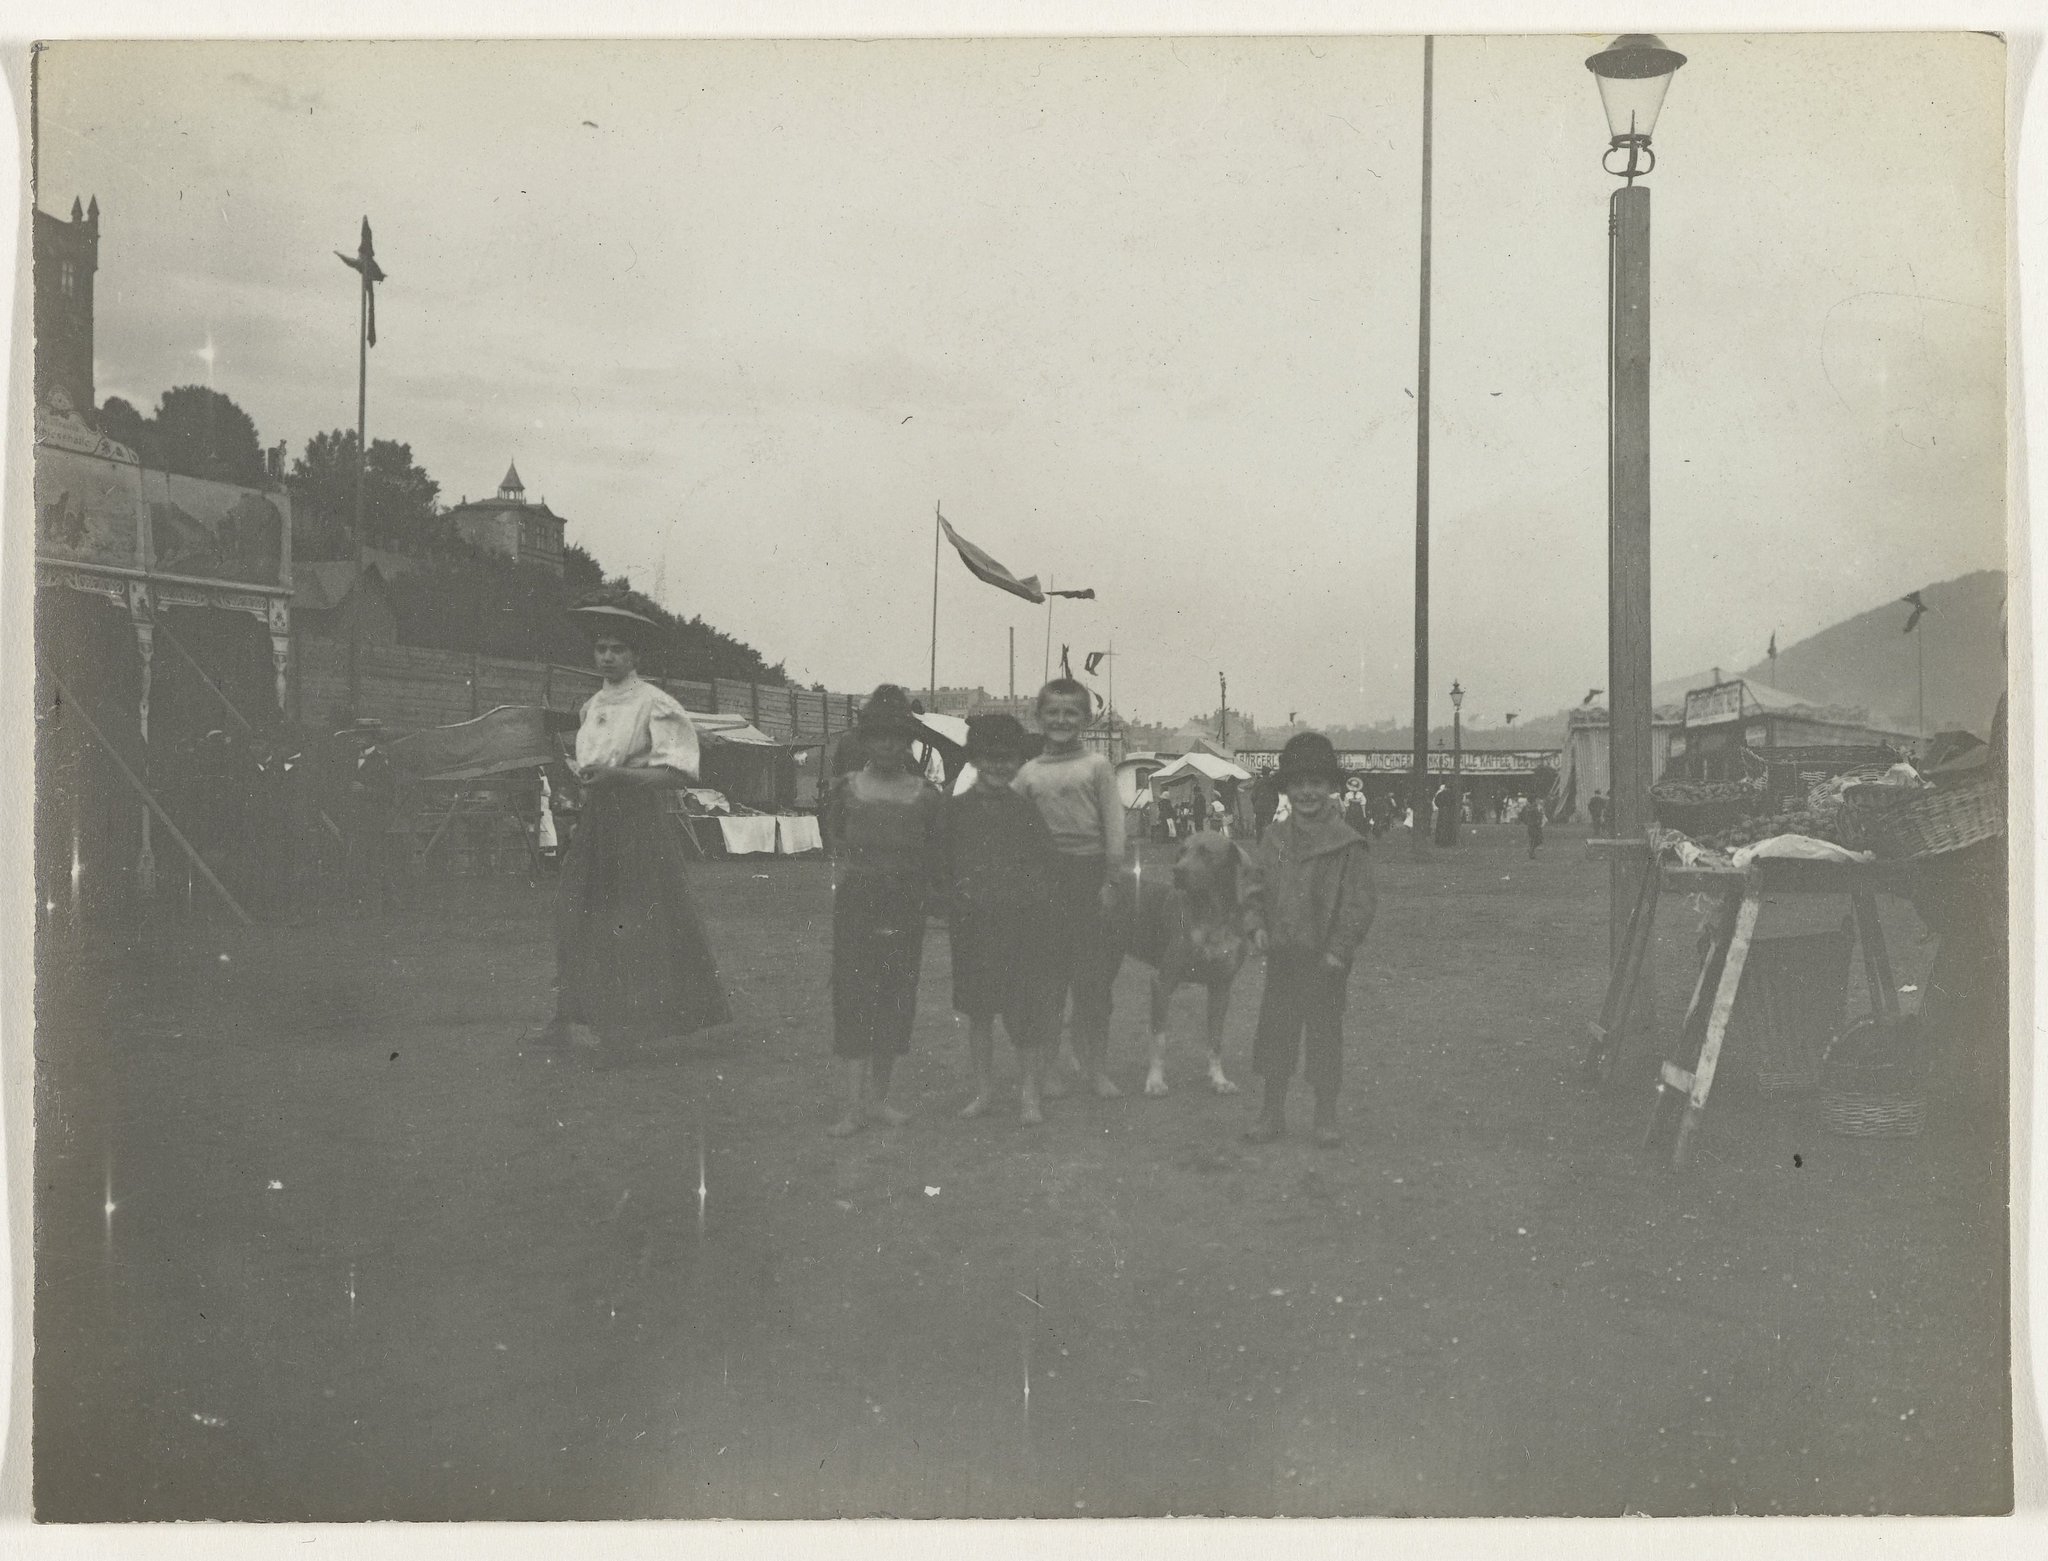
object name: photograph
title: Kinderen op een kermisterrein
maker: Anonymous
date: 1900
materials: paper, photographic support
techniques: gelatin silver print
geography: germany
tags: pleasure fair and circus, germany